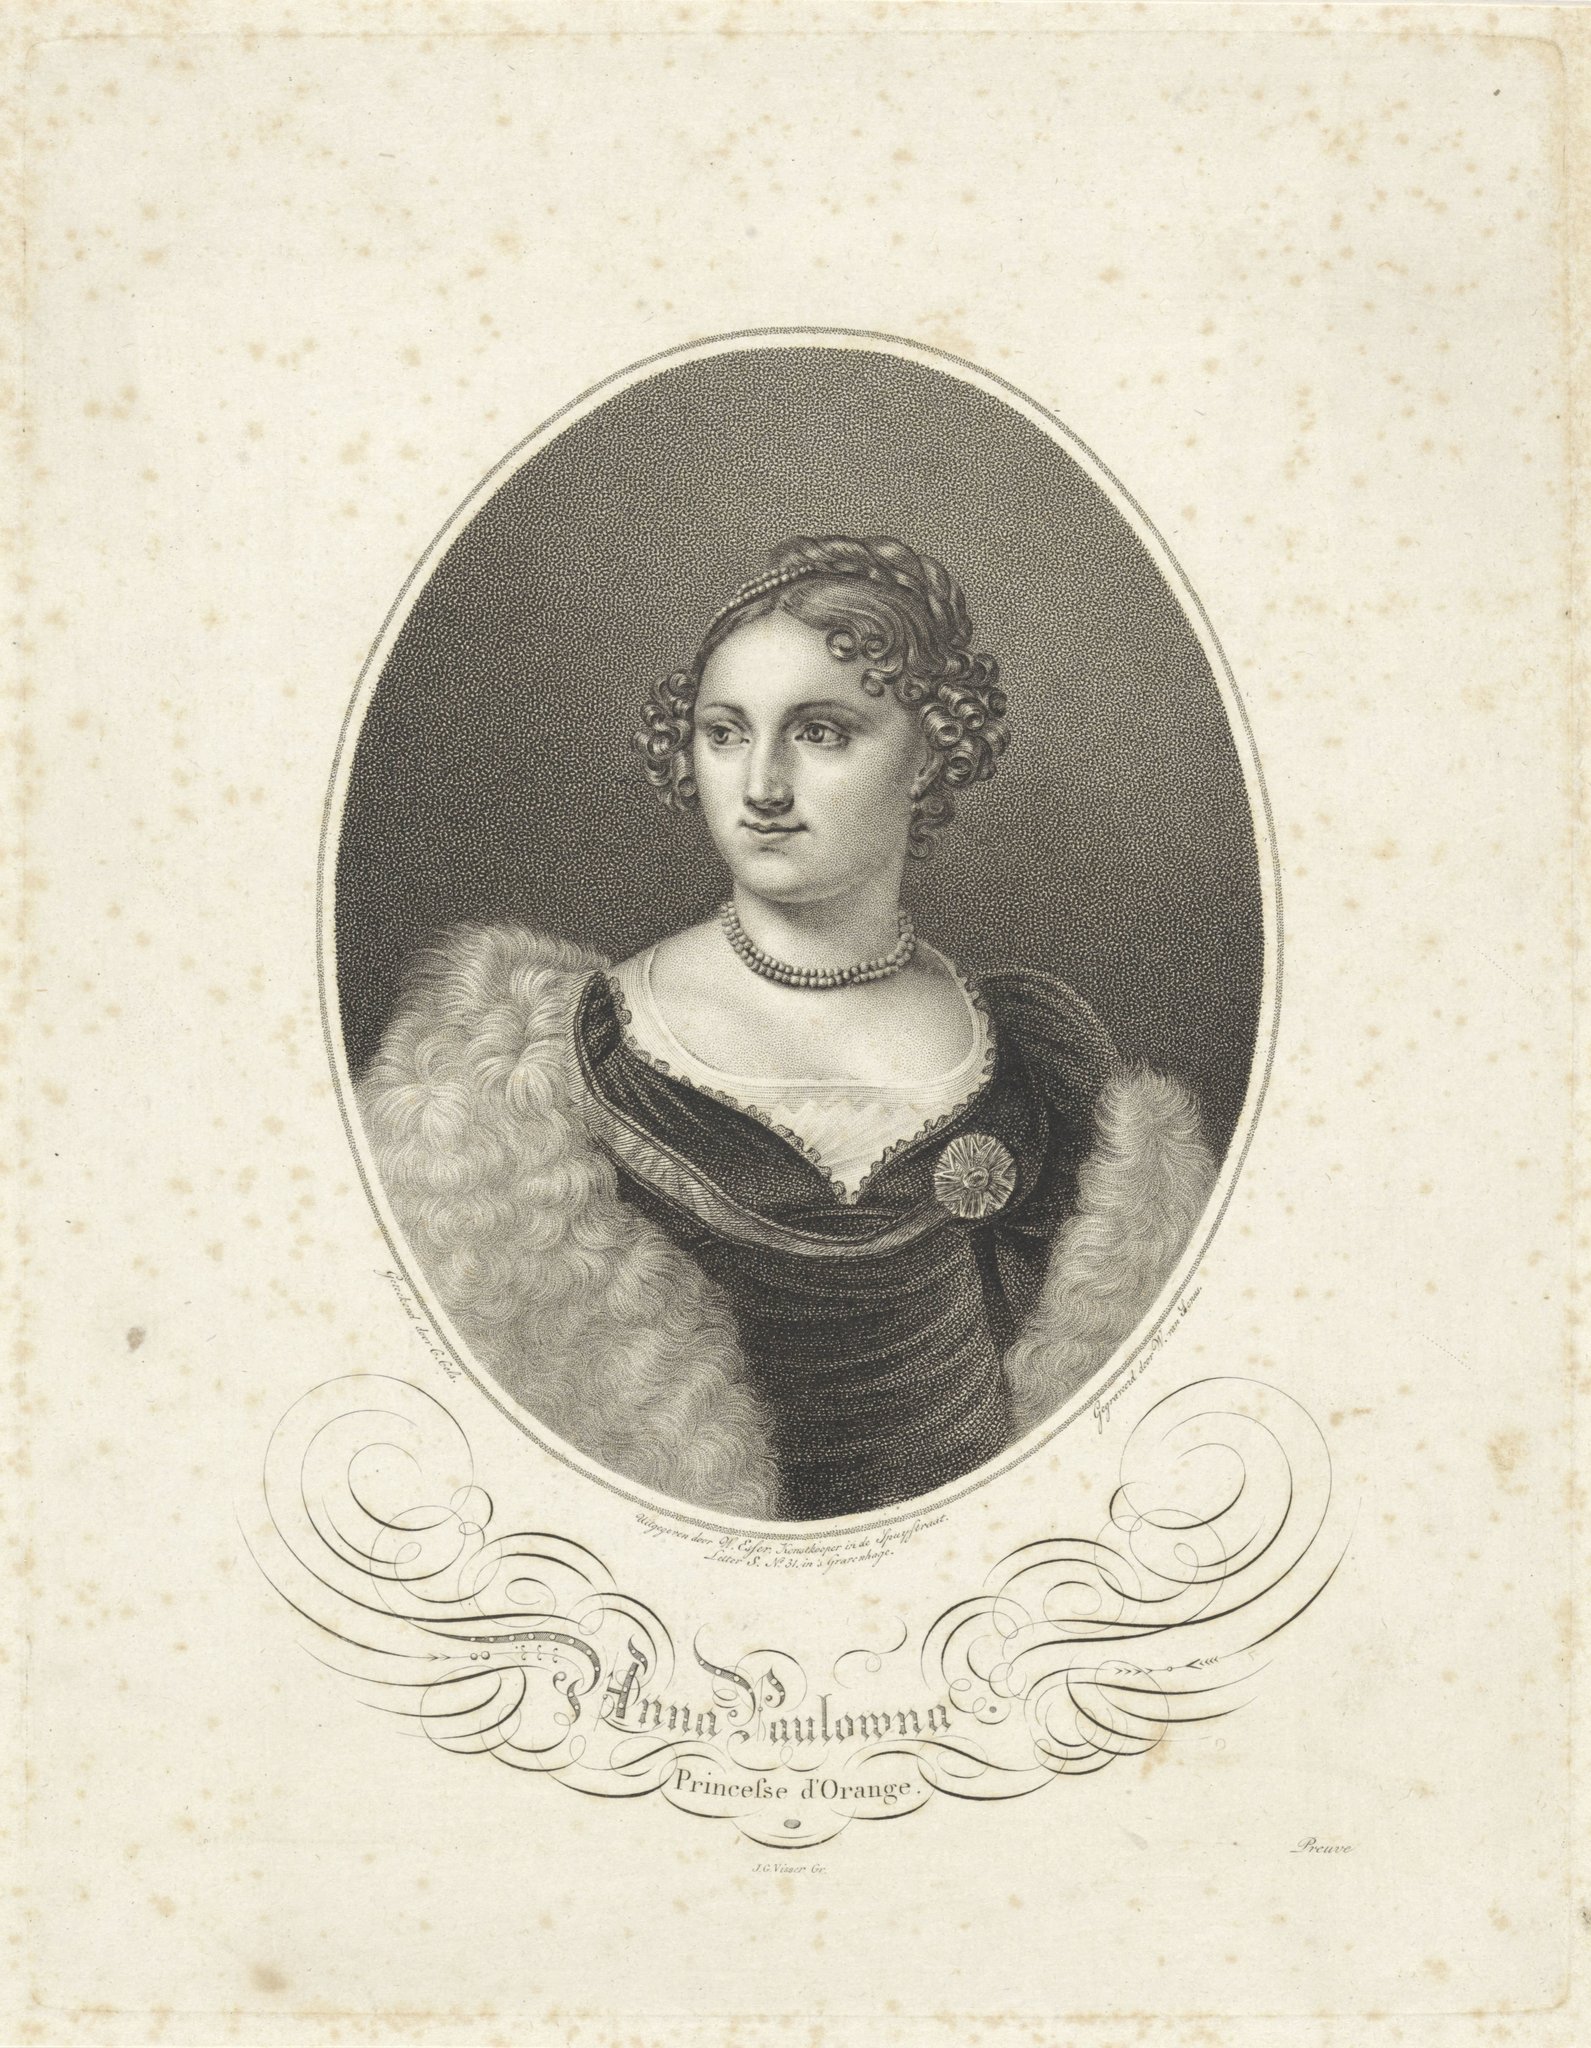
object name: print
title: Portret van Anna Paulowna Romanowa (koningin der Nederlanden)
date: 1816-1840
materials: paper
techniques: engraving, etching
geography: the hague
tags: the hague, anna paulowna romanowa, coat (+ fur used for clothes), pearl; pearl necklace (+ women's clothes)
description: Portret van Anna Paulowna Romanowa (koningin der Nederlanden), met parelsnoer en bontmantel.